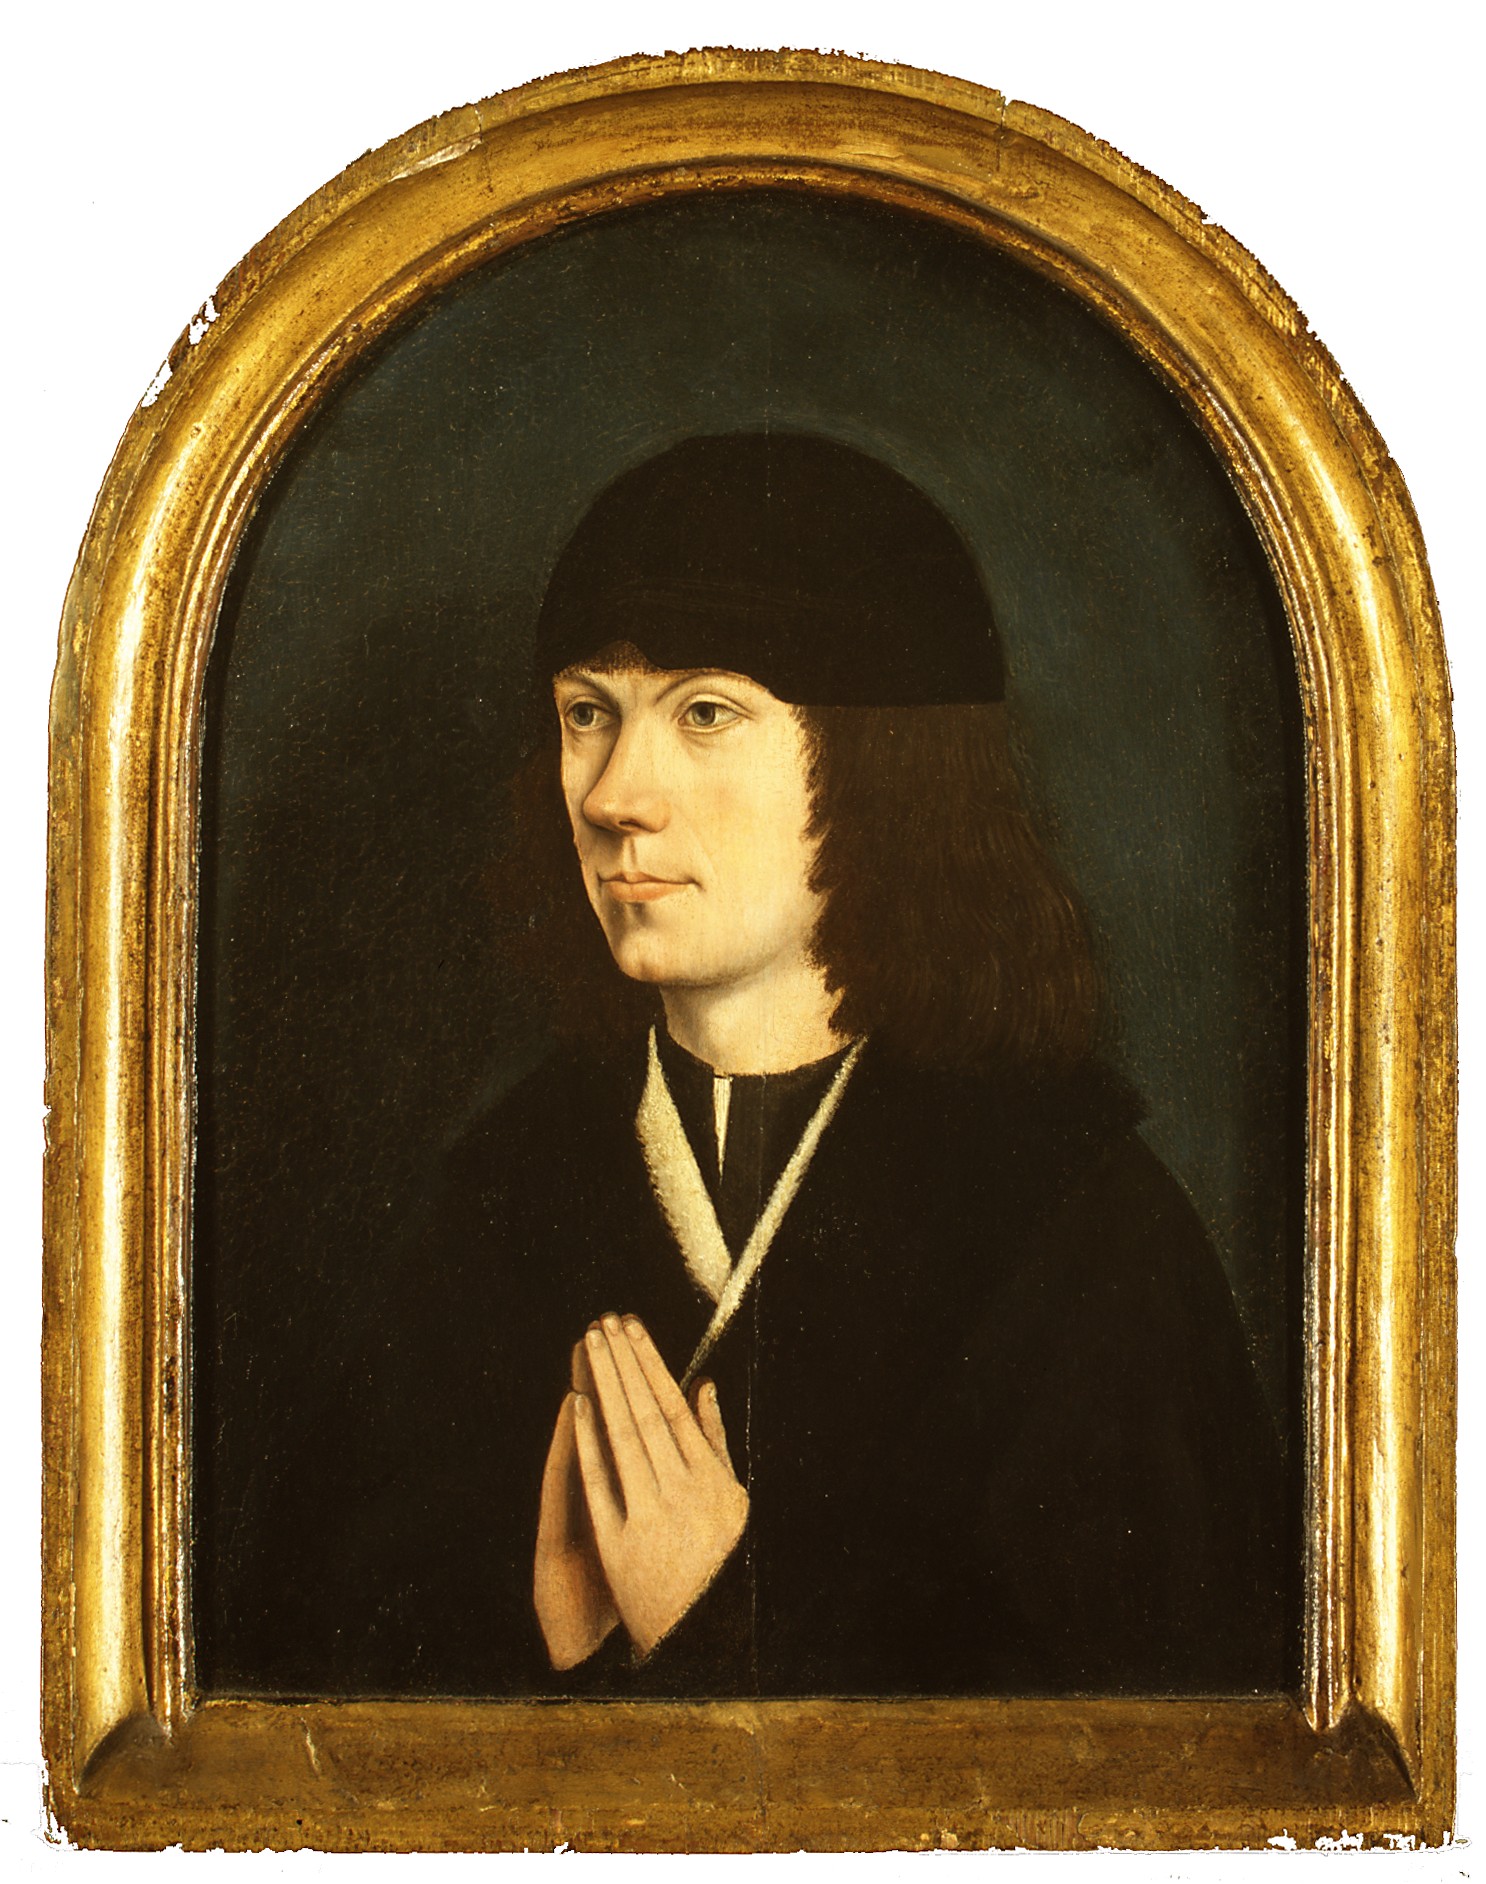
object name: painting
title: Portrait of a Young Man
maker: french (burgundian?) painter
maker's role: artist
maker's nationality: french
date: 1490-1500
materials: oil, wood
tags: men,portraits